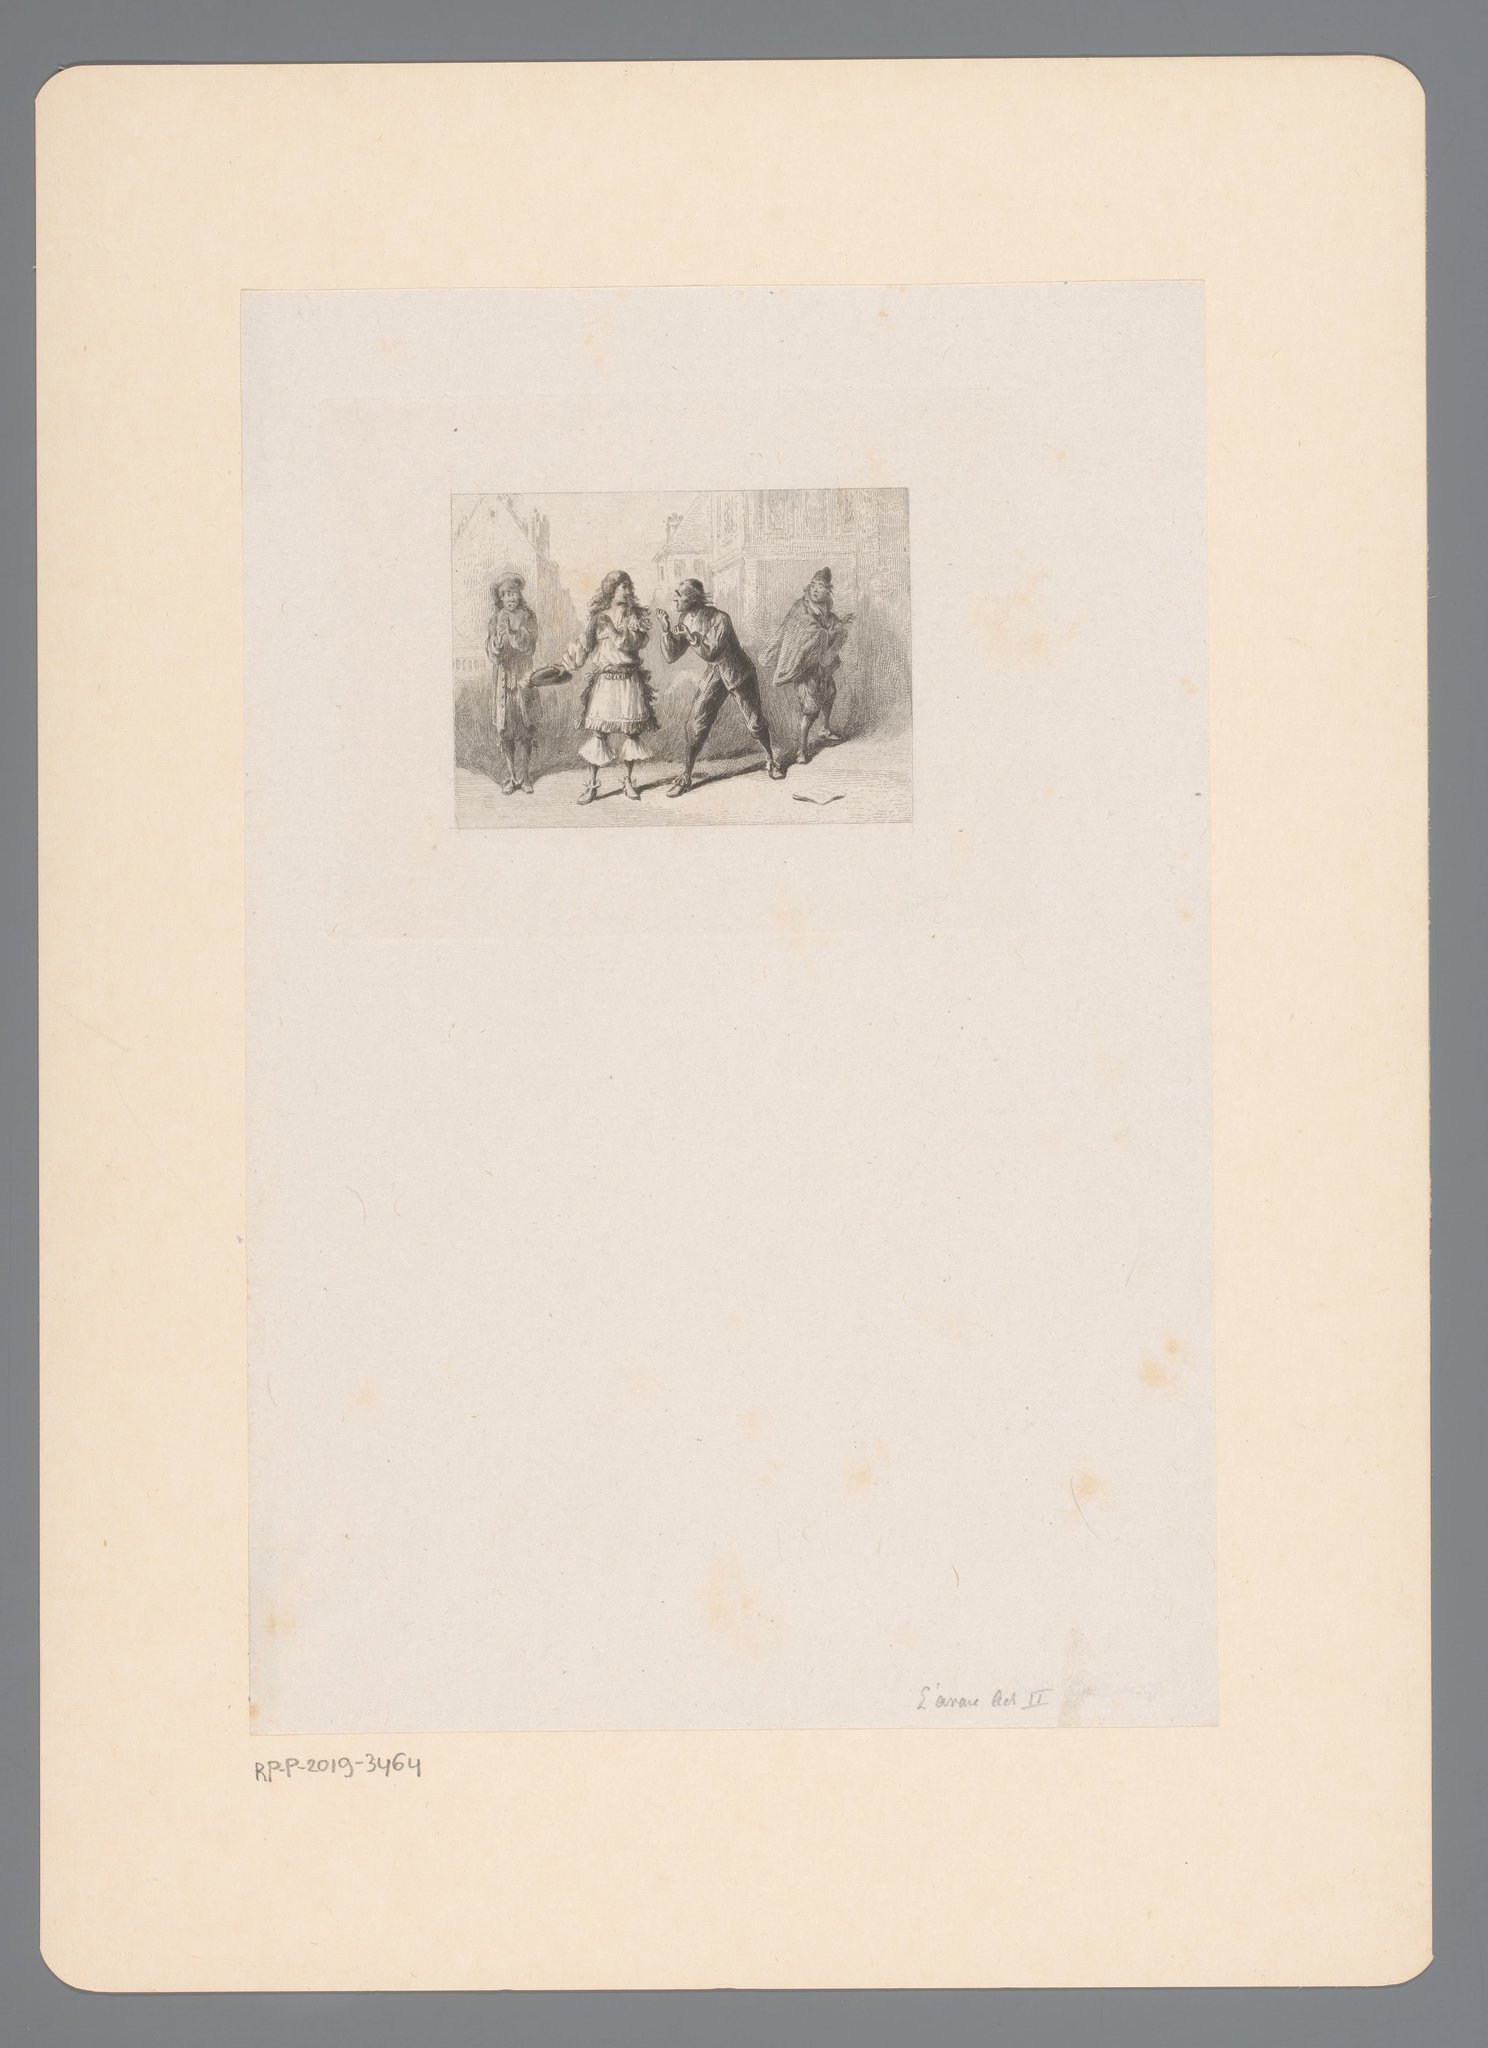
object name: print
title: Harpagon bedreigt Cléante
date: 1878-1879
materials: paper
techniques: drypoint, etching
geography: tours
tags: theatre, theatrical performance, miser, nobility and patriciate; chivalry, knighthood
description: Scène uit akte II uit "L'Avare" van Molière. Cléante ontdekt dat zijn geldschieter eigenlijk zijn vader Harpagon is en ze krijgen ruzie.